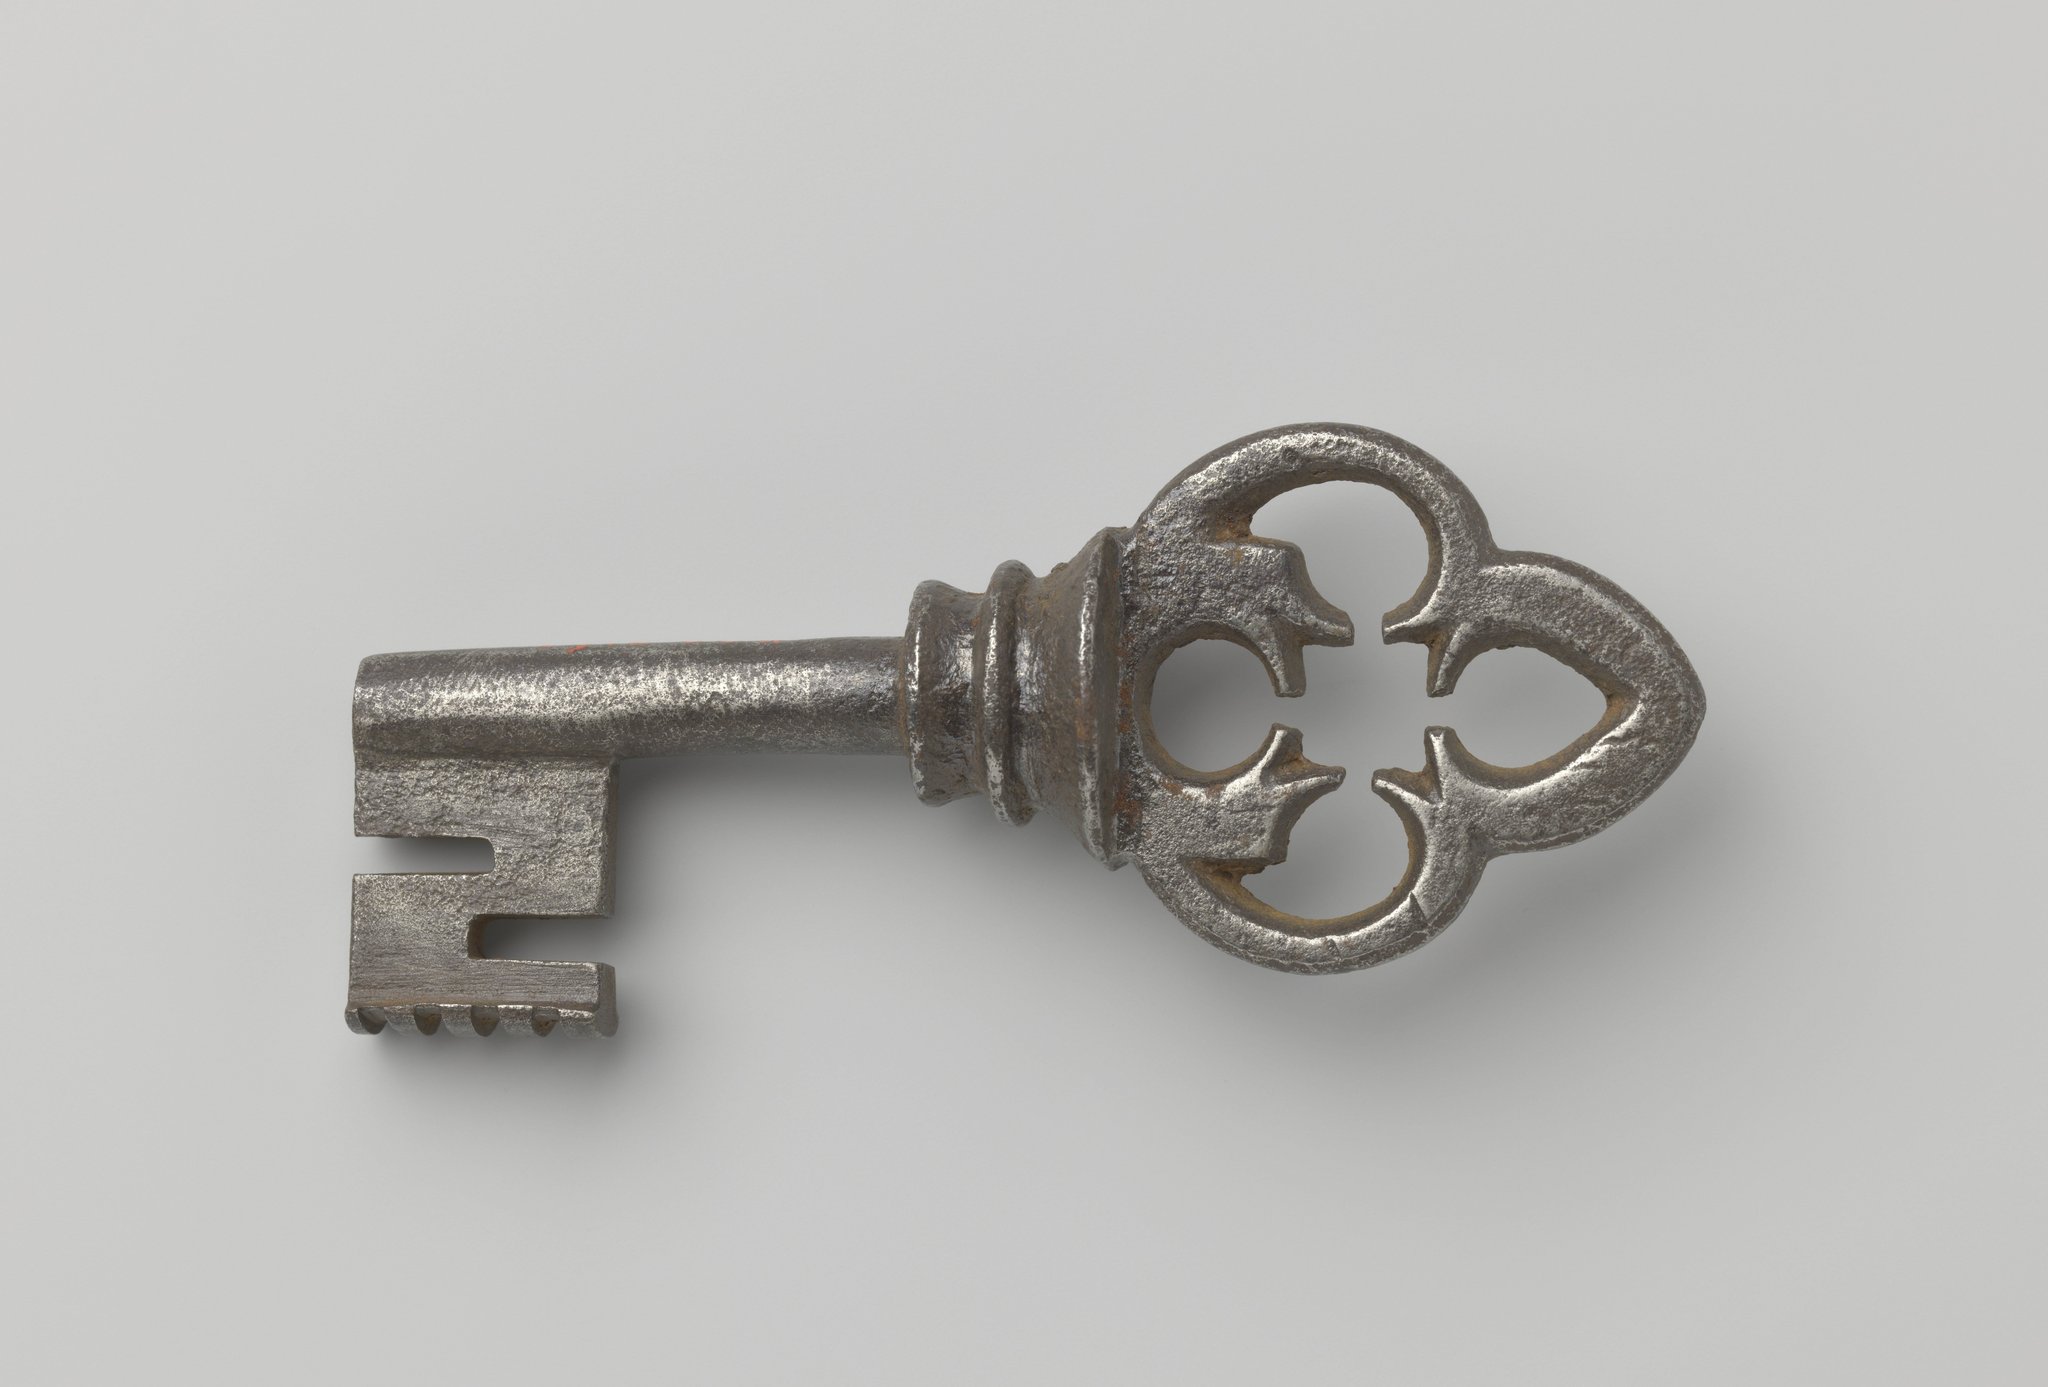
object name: pipe key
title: Pijpsleutel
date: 1400-1500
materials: iron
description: Pijpsleutel waarvan de driepasvormige greep met gespleten binnenkoeken rust op een vijzelvormig kapiteel.